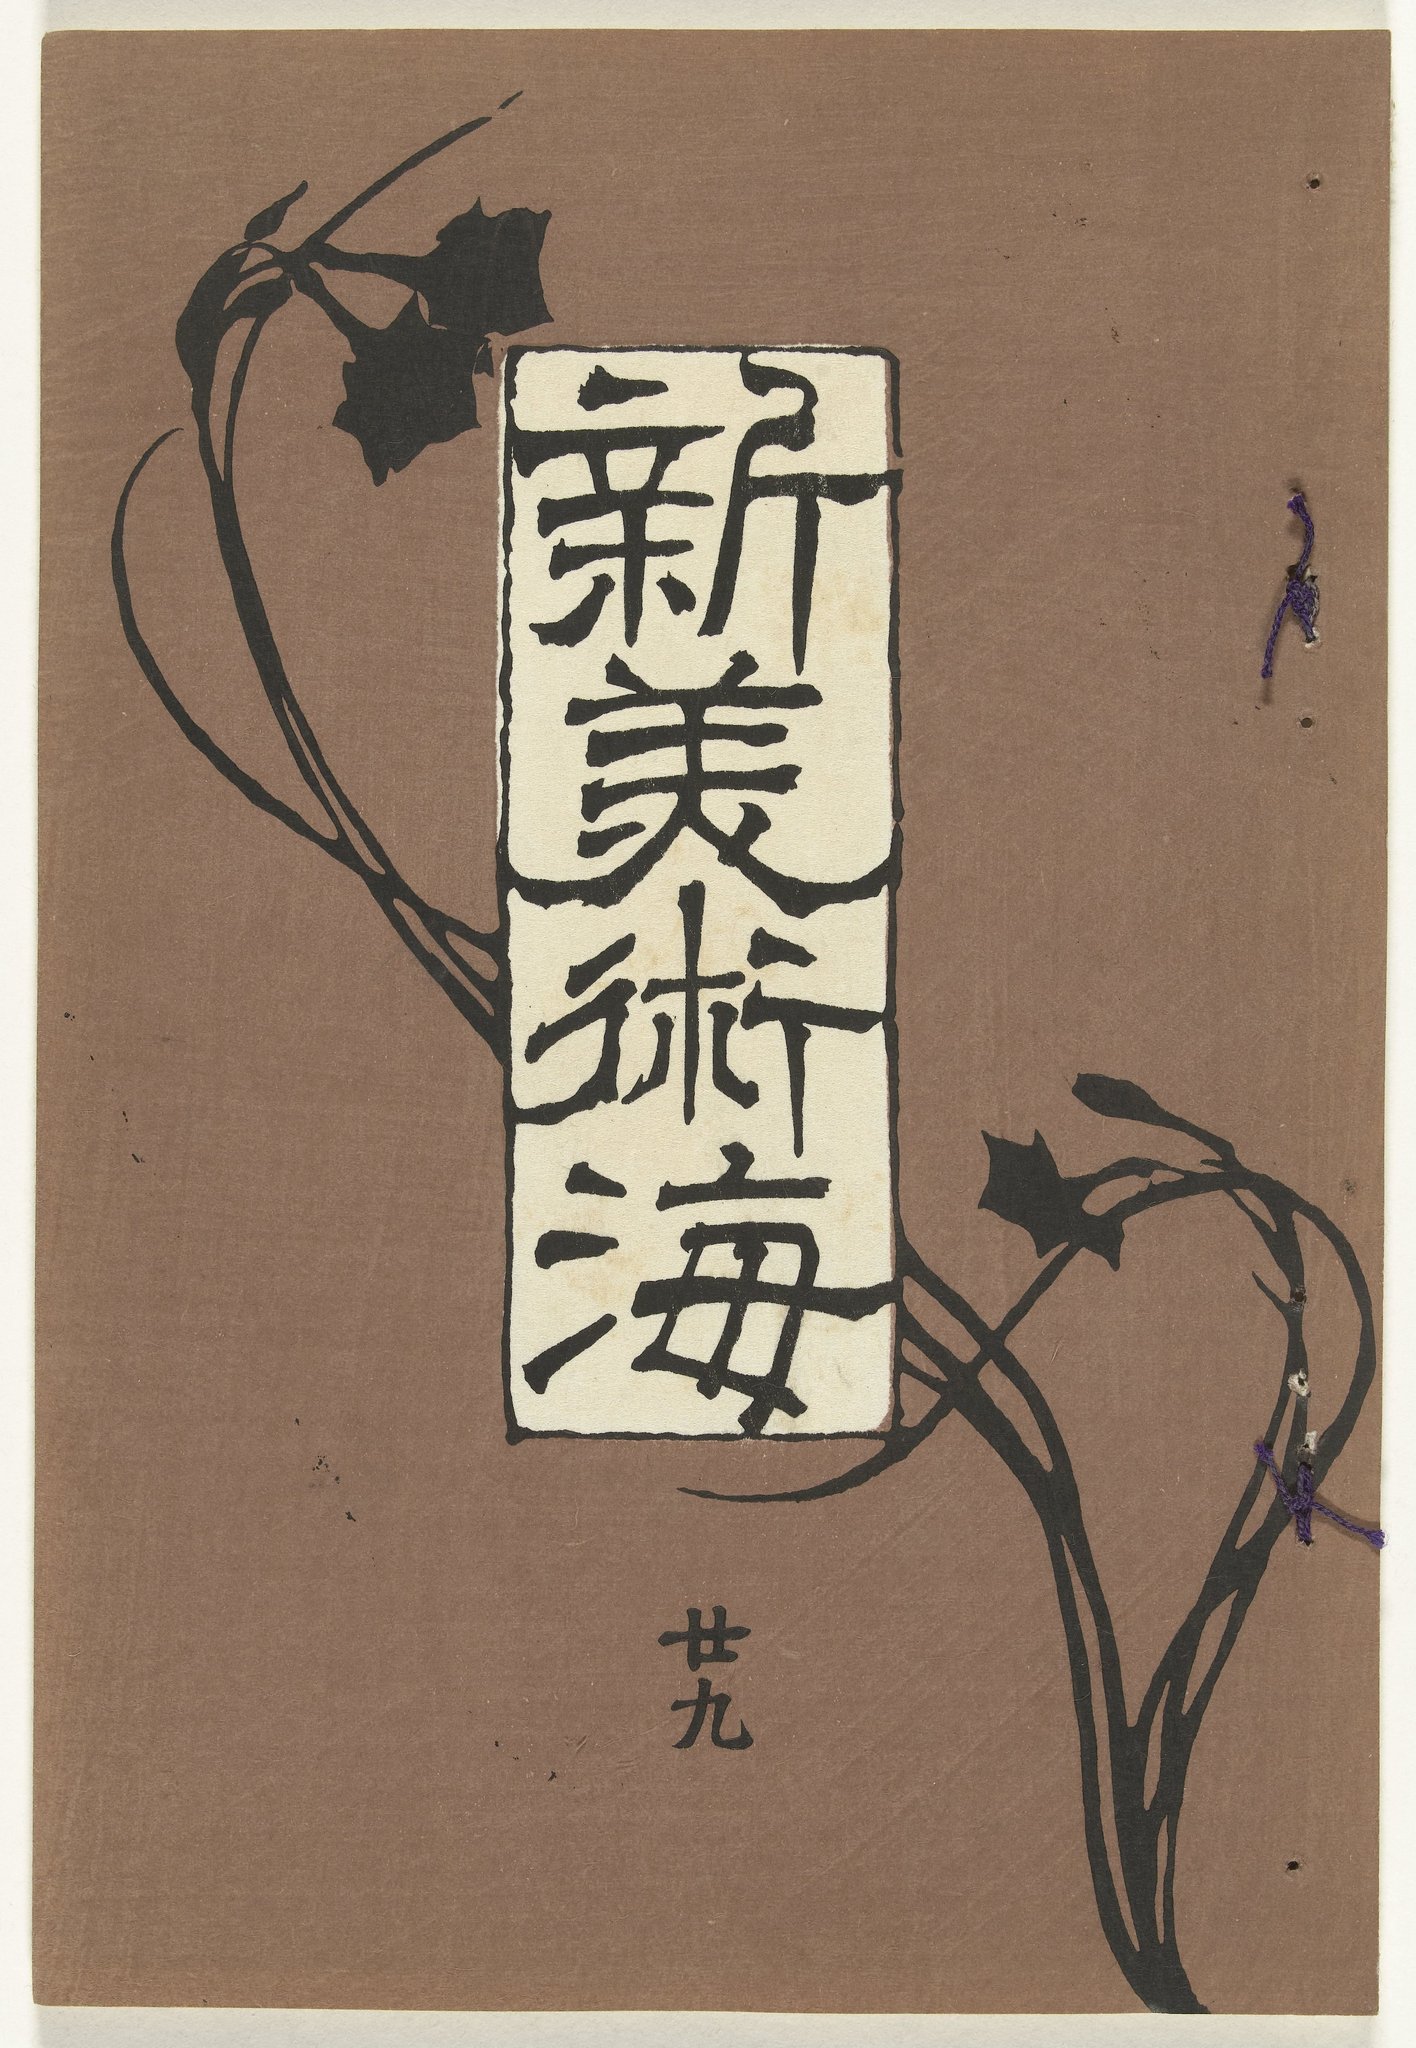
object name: book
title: Nieuwe zee der kunsten - 29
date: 1905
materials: paper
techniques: woodcut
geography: kyoto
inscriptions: date